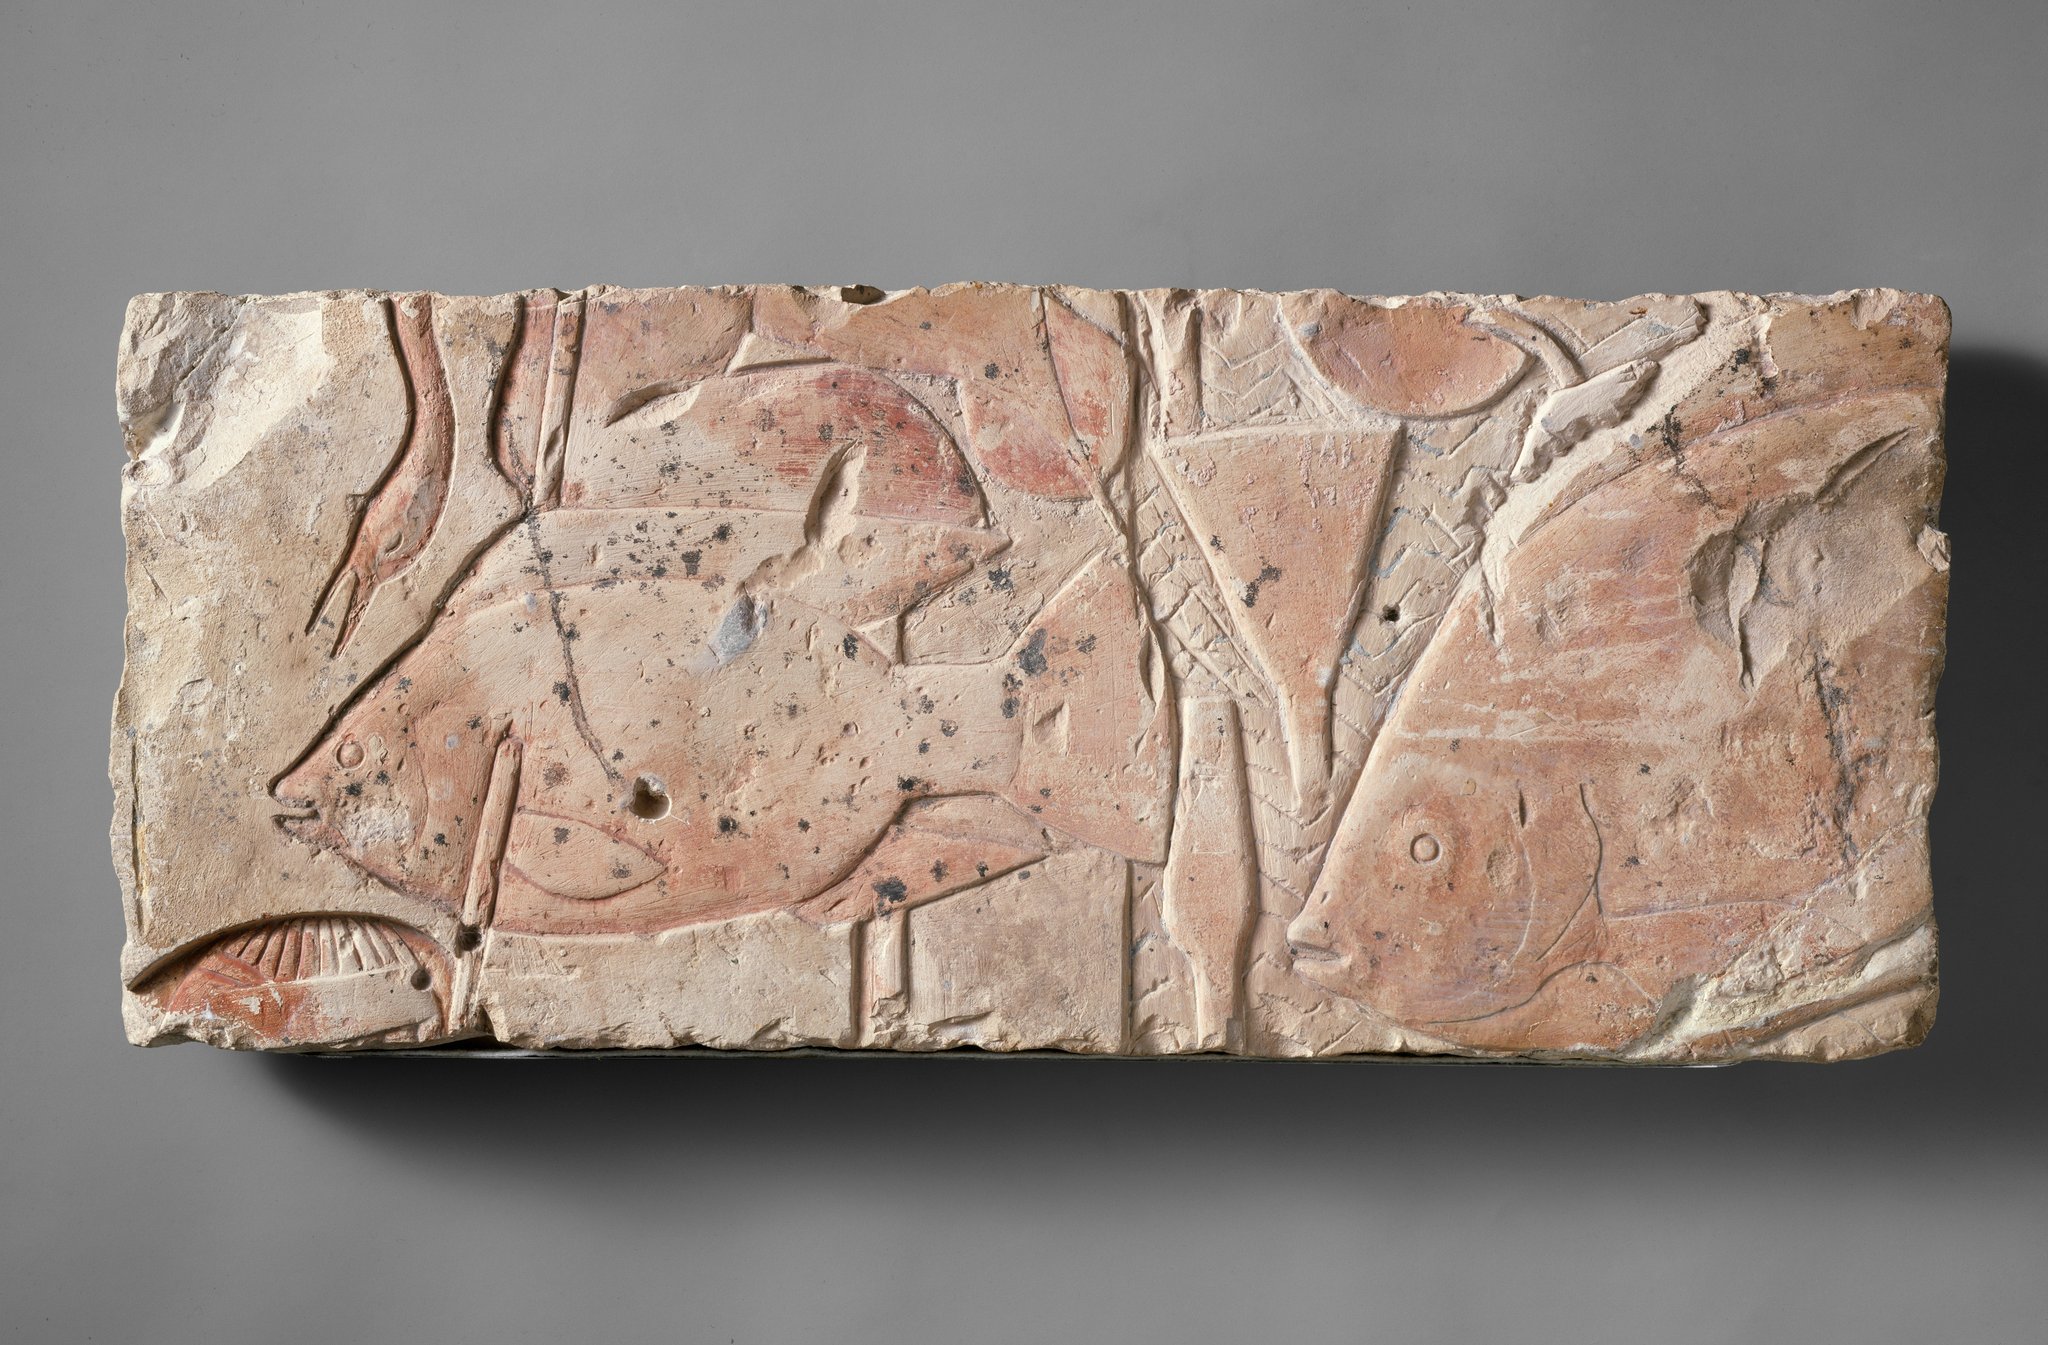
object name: talatat, fishing, fowling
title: Scene of Fishing and Fowling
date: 1353-1336 BCE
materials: limestone, paint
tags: fishing,fish